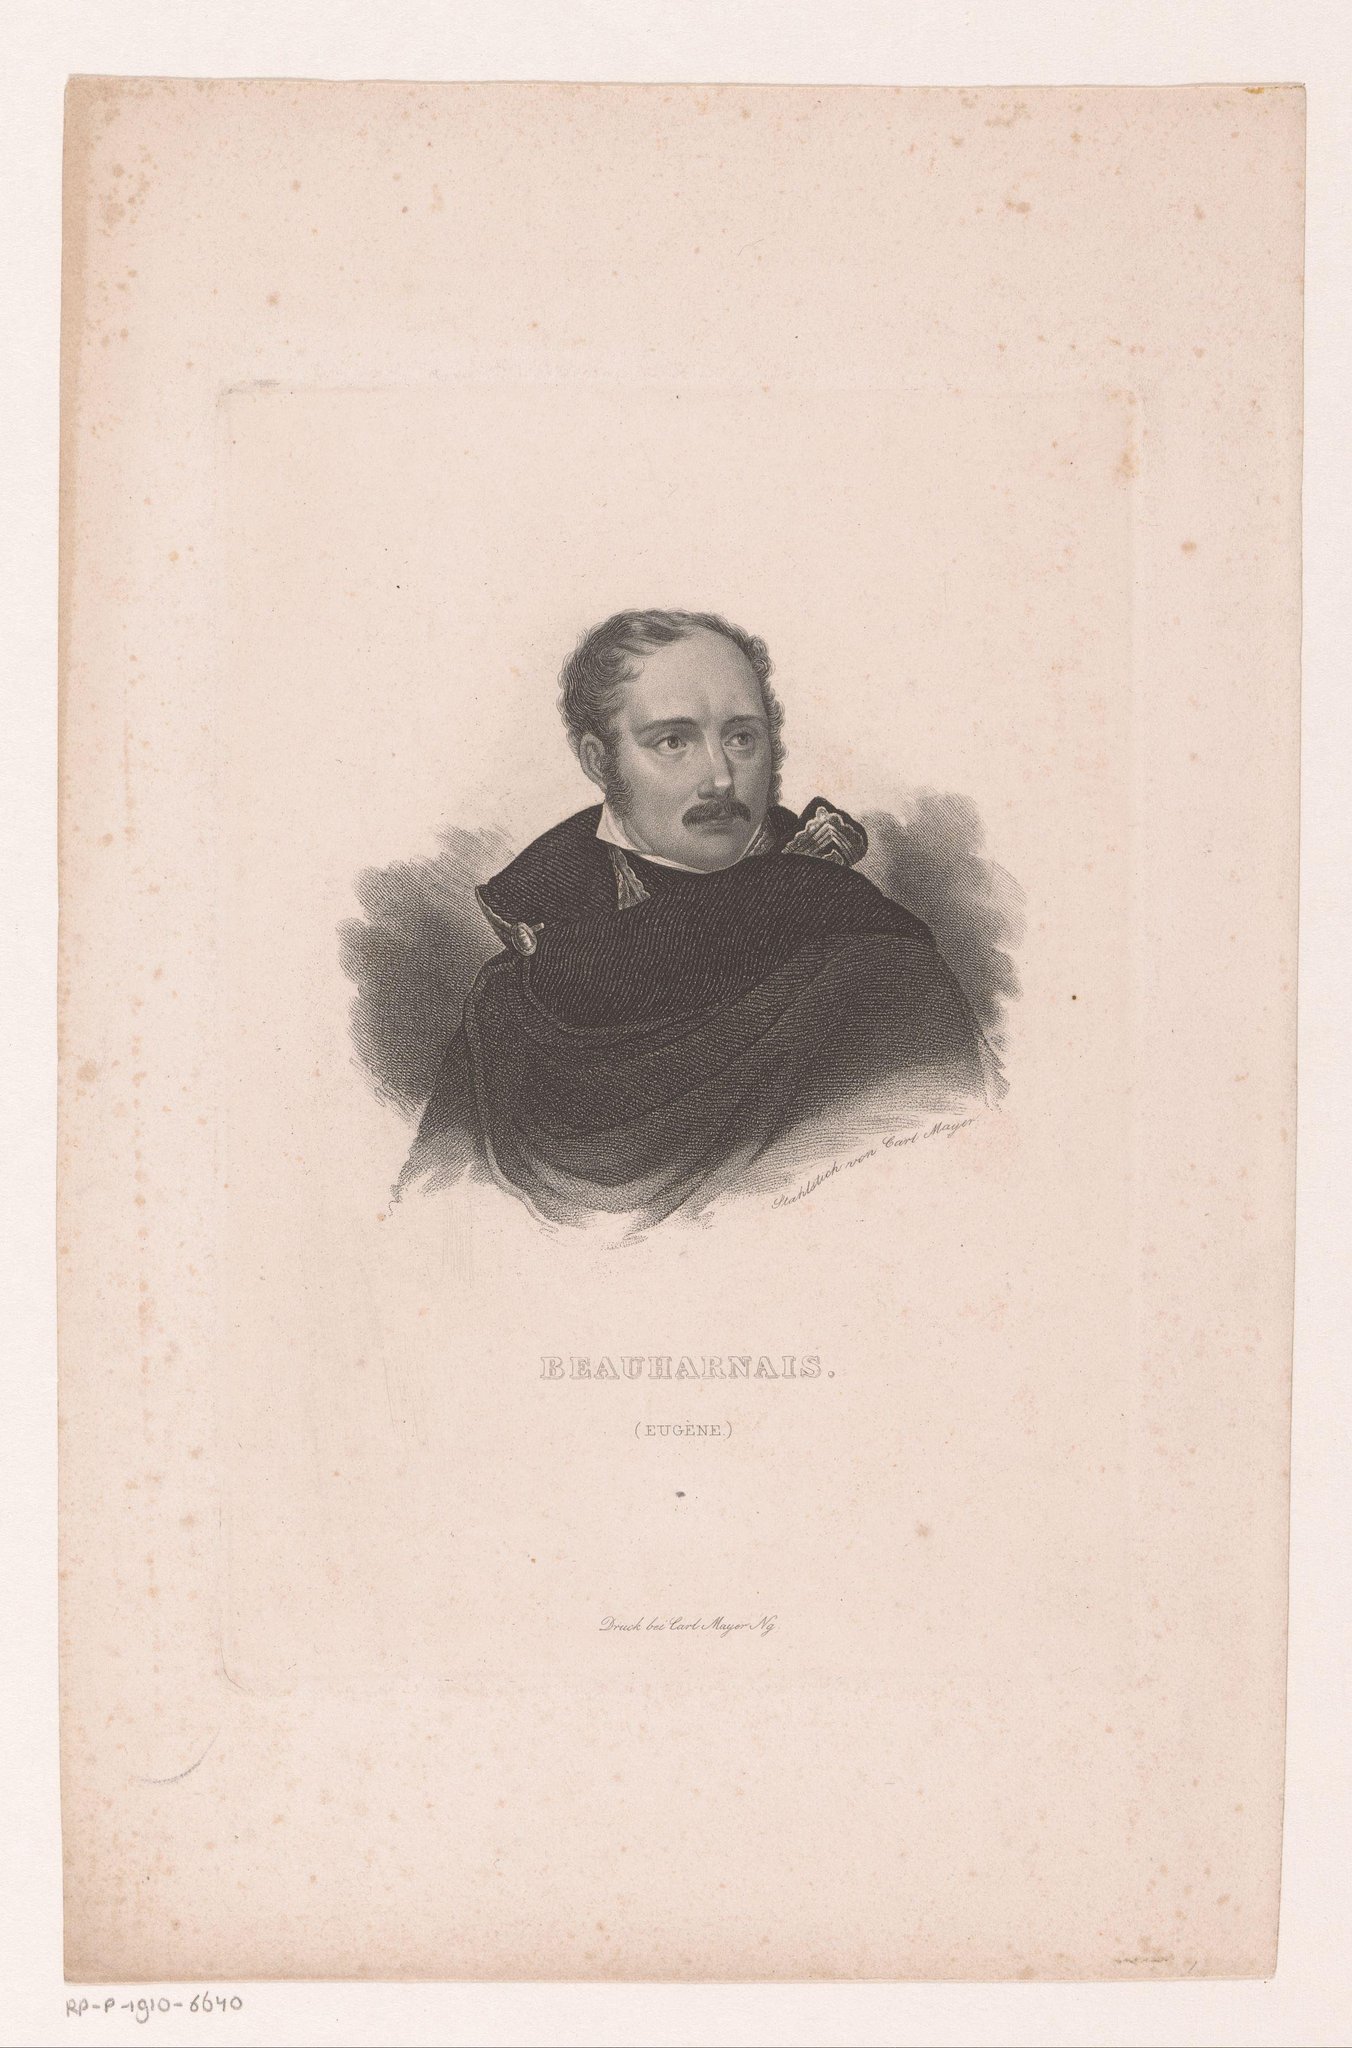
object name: print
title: Portret van Eugène de Beauharnais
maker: carl mayer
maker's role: print maker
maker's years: 1798-1868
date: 1808-1868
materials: paper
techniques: engraving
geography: nuremberg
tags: paris, eugène de beauharnais, historical persons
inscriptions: collector's mark: Lugt 2228